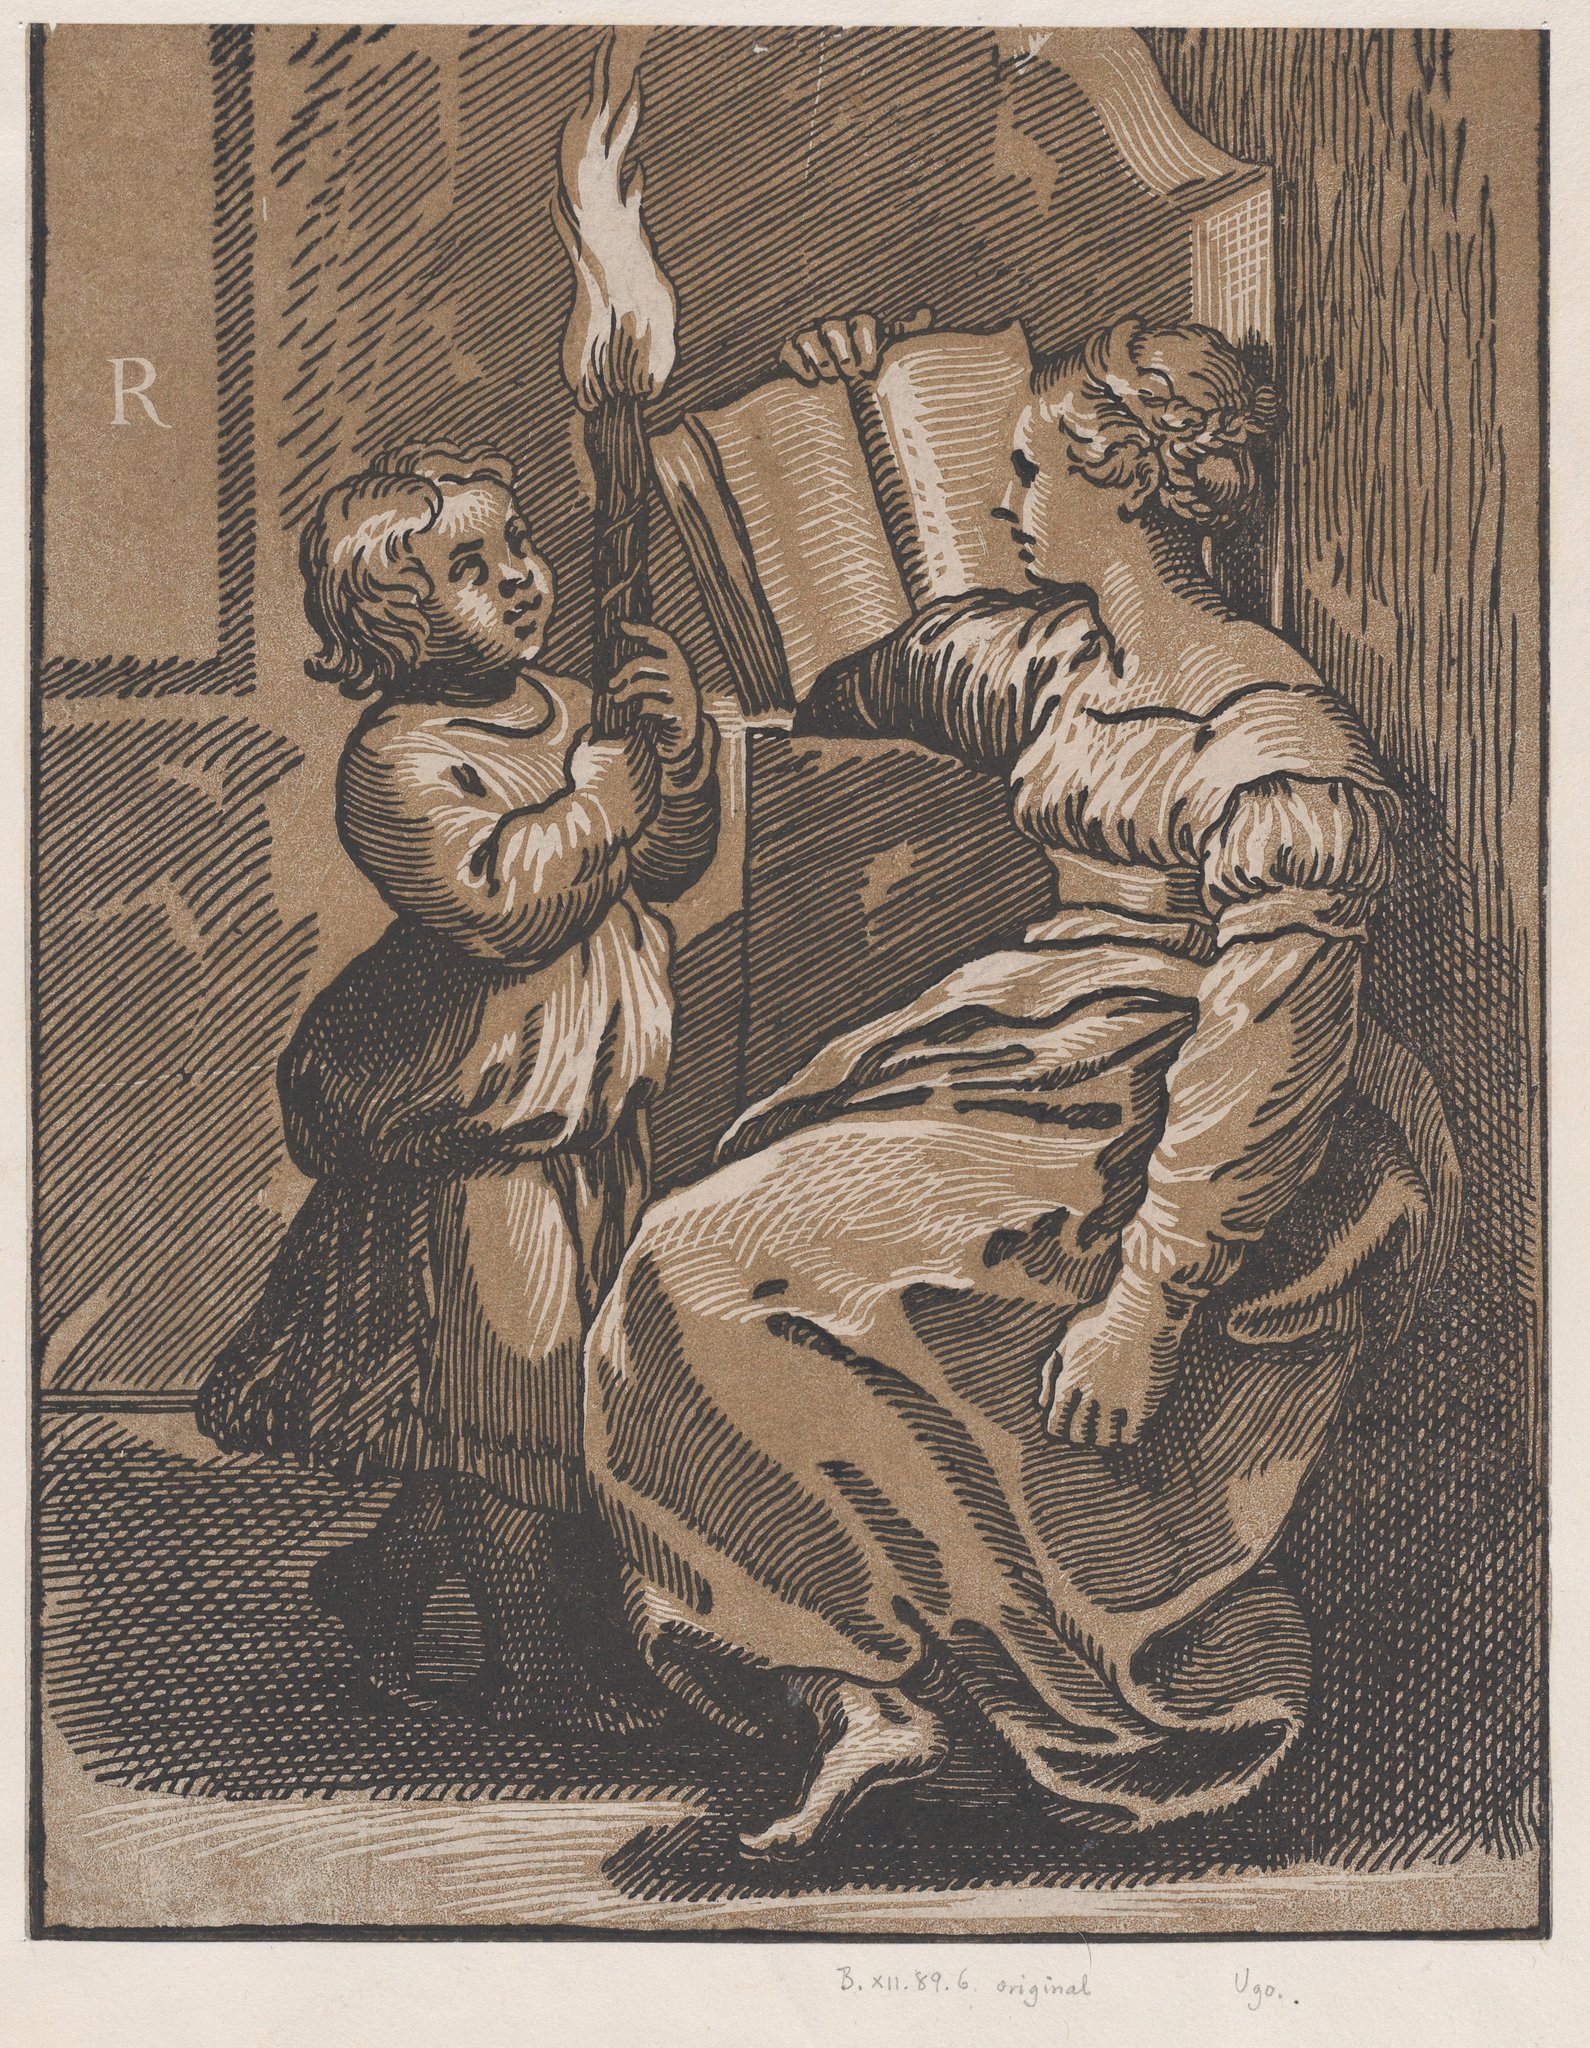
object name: print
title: A Sibyl reading a book facing left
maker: ugo da carpi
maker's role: artist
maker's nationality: italian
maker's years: 1480-1532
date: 1518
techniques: woodcut